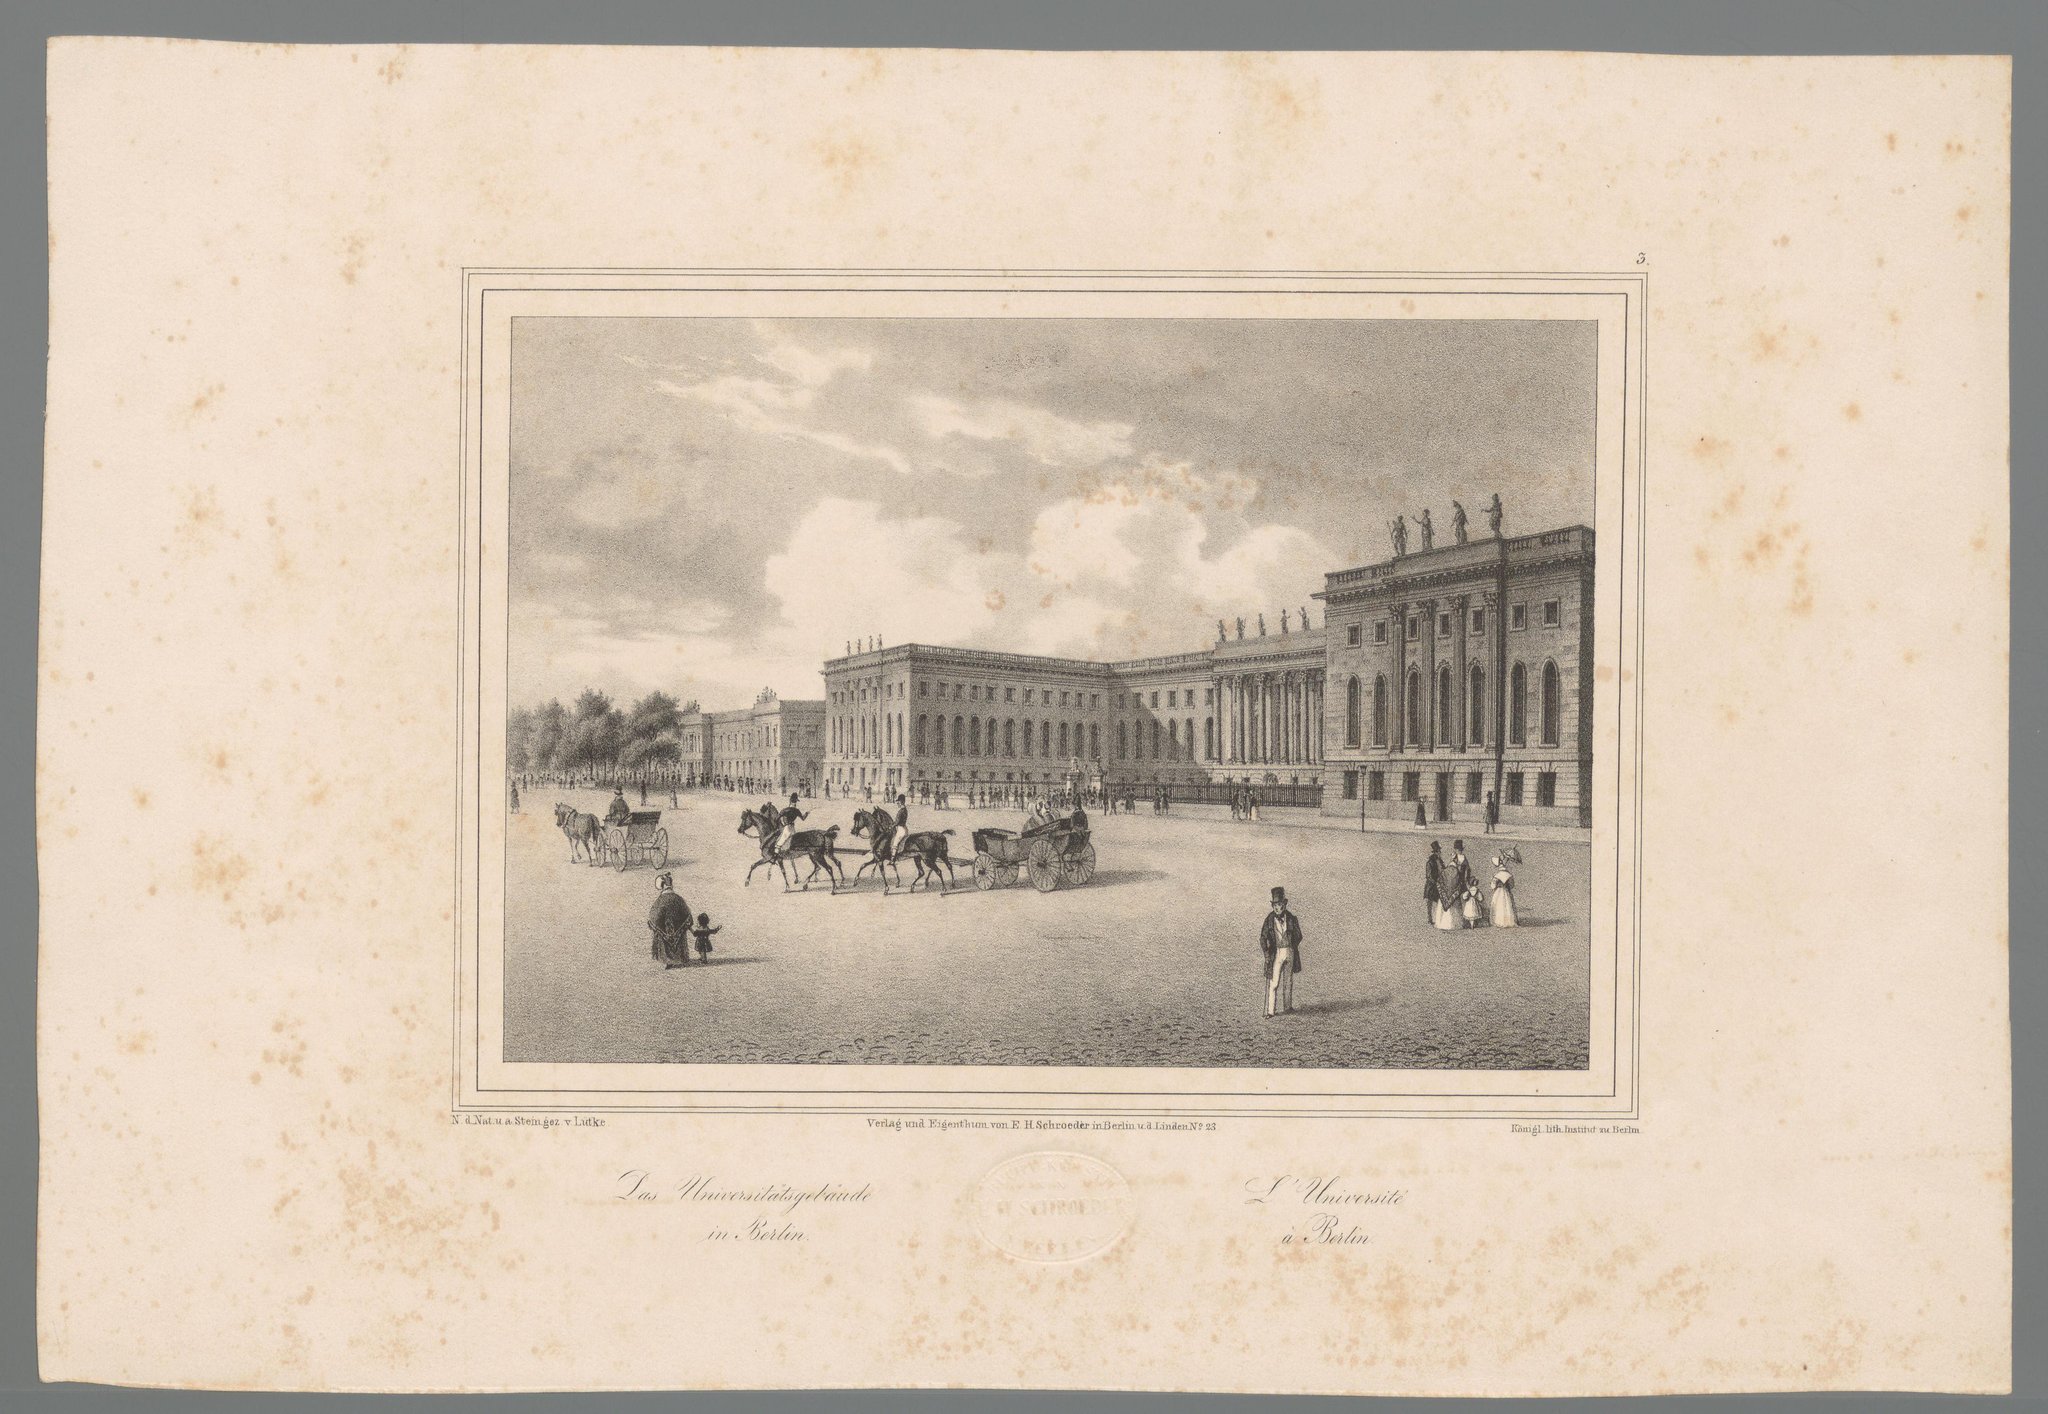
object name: print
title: Landschappen en stadsgezichten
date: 1840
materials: paper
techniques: lithograph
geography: berlin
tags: city-view in general; 'veduta', university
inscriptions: check stamp: ‘Buch u. Kunsth. von E.H. Schroeder in Berlin’, collector's mark: Lugt 2228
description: Gezicht op universiteitsgebouwen in Berlijn, destijds bekend als de Friedrich-Wilhelms-Universität. Rechtsboven genummerd: 3.